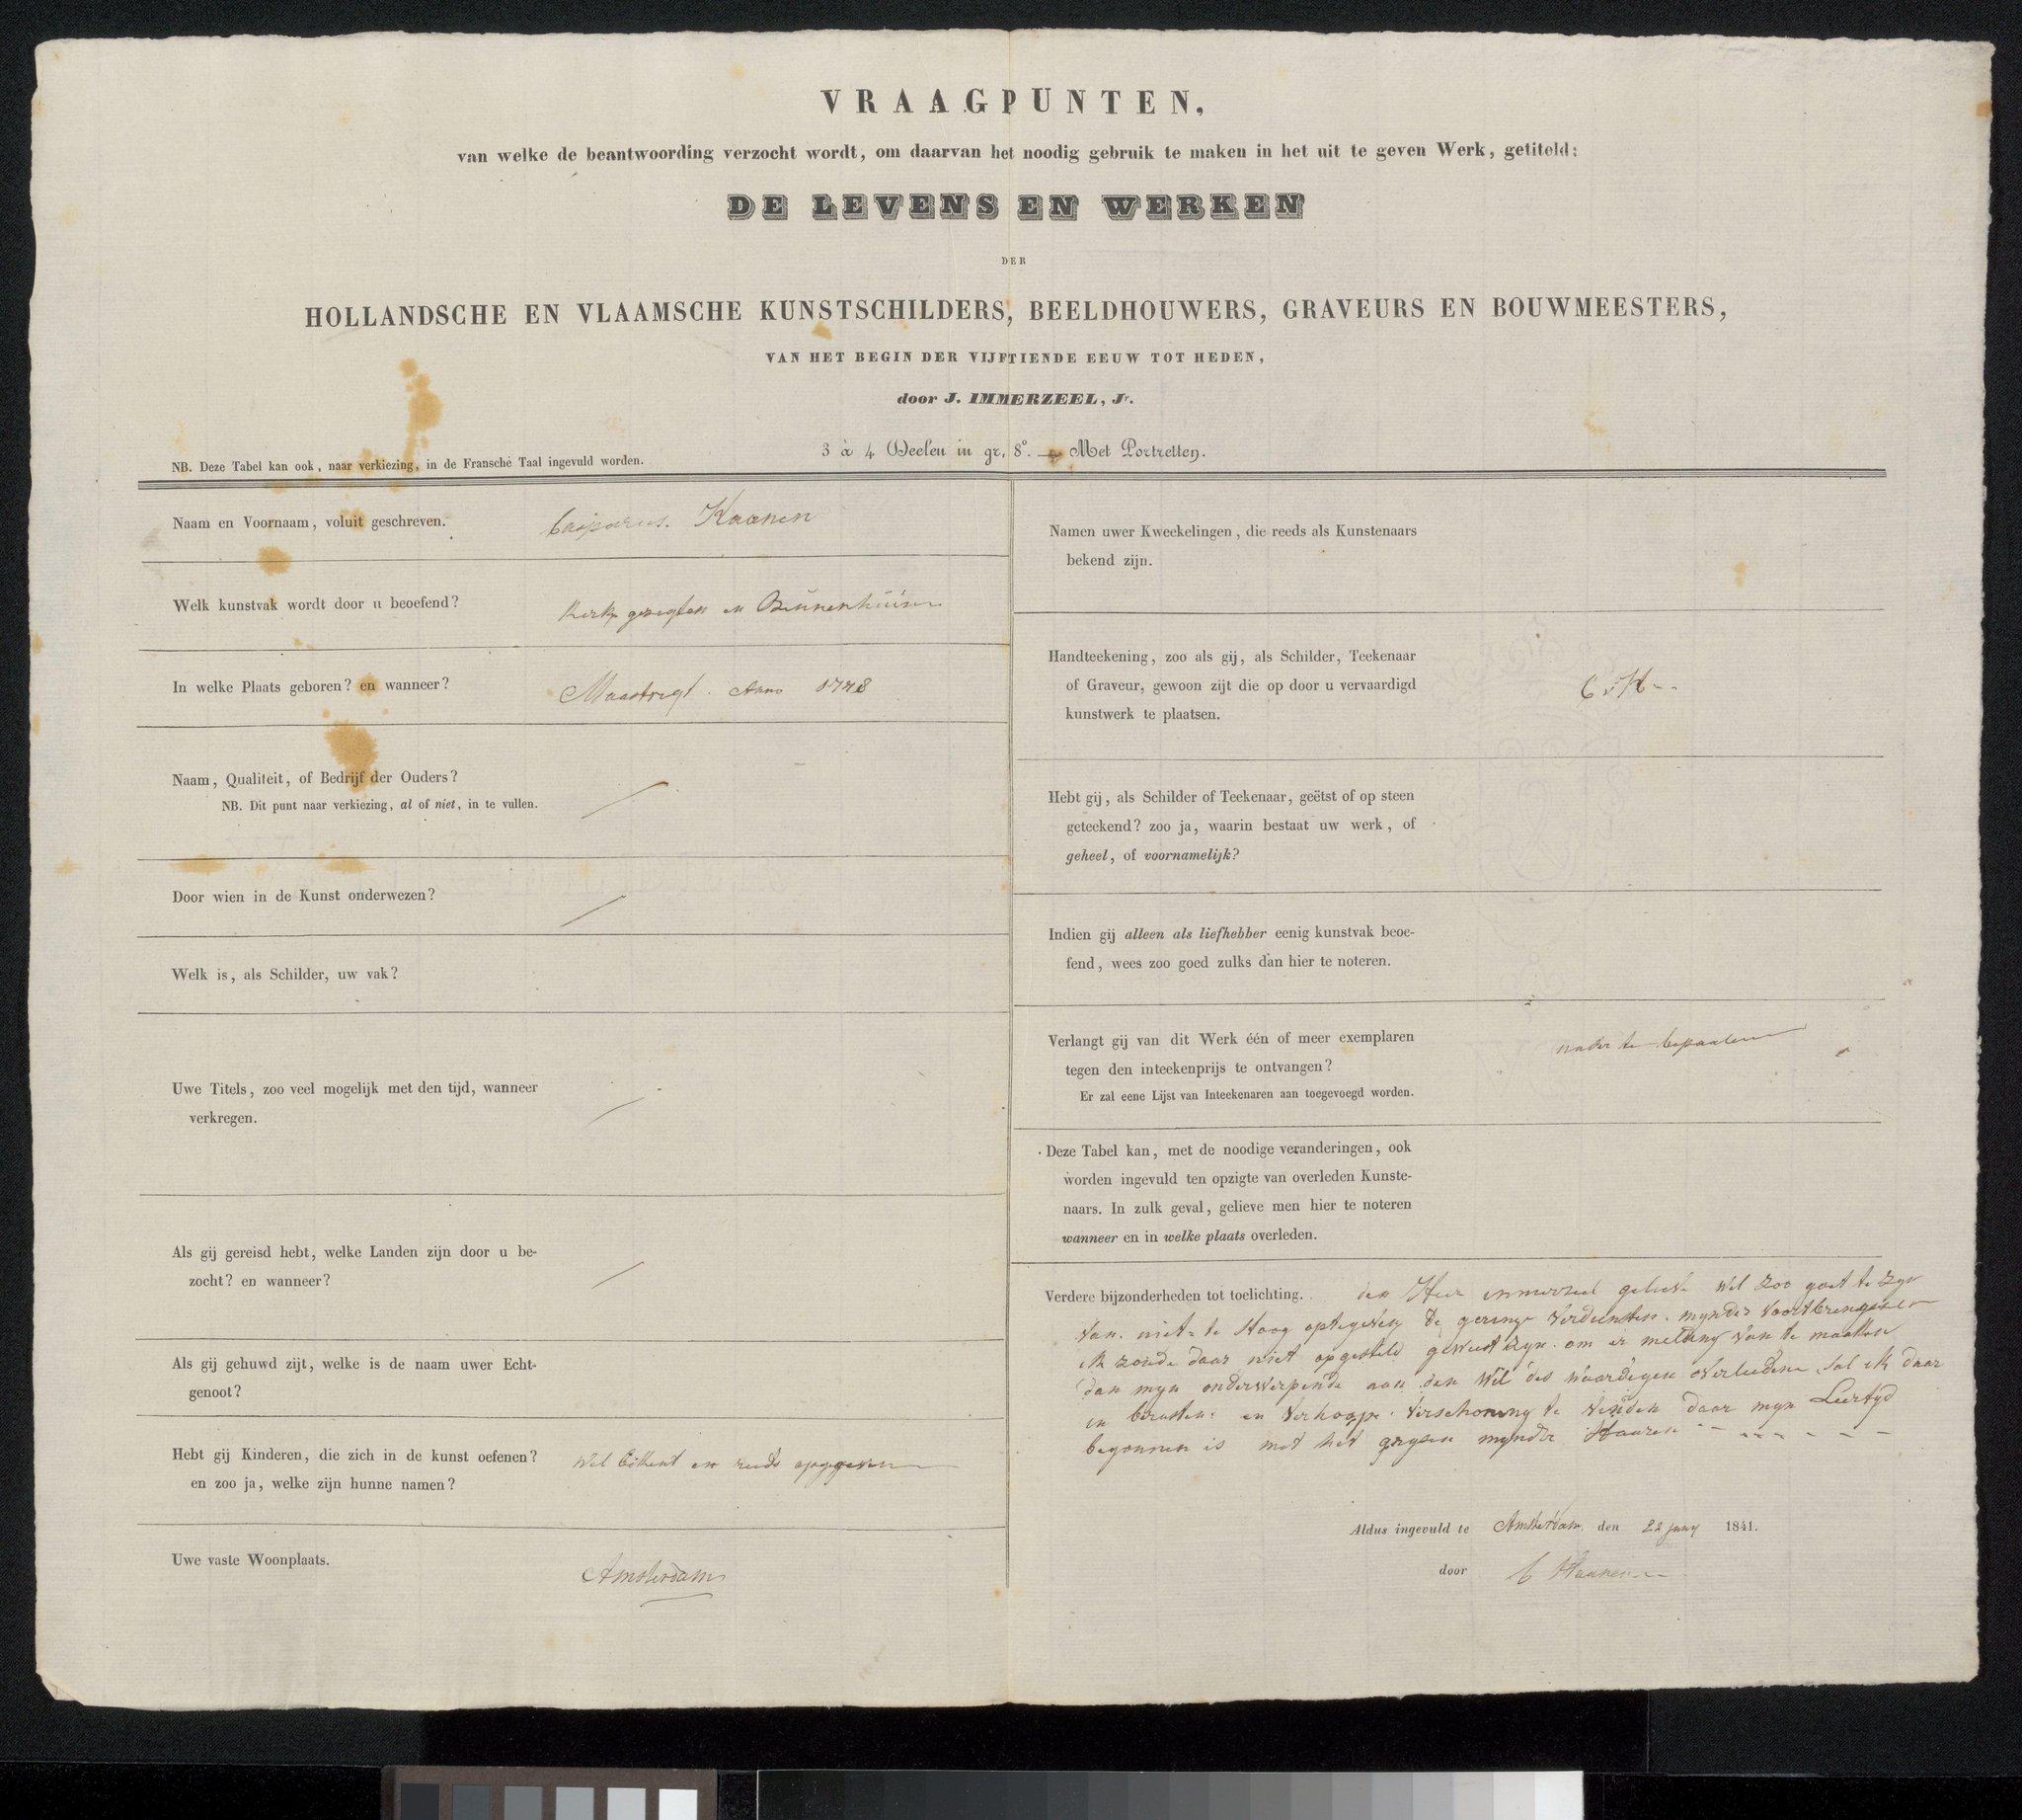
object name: questionnaire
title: Enquêteformulier ingevuld door Casparis Haanen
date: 1841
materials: ink, paper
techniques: pen, printing, writing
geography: amsterdam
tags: maastricht, amsterdam, draughtsman, casparis haanen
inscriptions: inscription: ‘Vraagpunten,/ van welke de beantwoording verzocht wordt, om daarvan het noodig gebruik te maken in het uit te geven Werk, getiteld: De levens en werken/ der Hollandsche en Vlaamsche kunstschilders, beeldhouwers,/ graveurs en bouwmeesters, van het begin der vijftiende eeuw tot heden/ door J. Immerzeel, Jr.’, watermark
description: Opgenomen in: Immerzeel, J. Jr., De levens en werken der Hollandsche en Vlaamsche kunstschilders, beeldhouwers, graveurs en bouwmeesters, van het begin der vijftiende eeuw tot heden, Amsterdam: J.C. van Kesteren, 1842-1843.